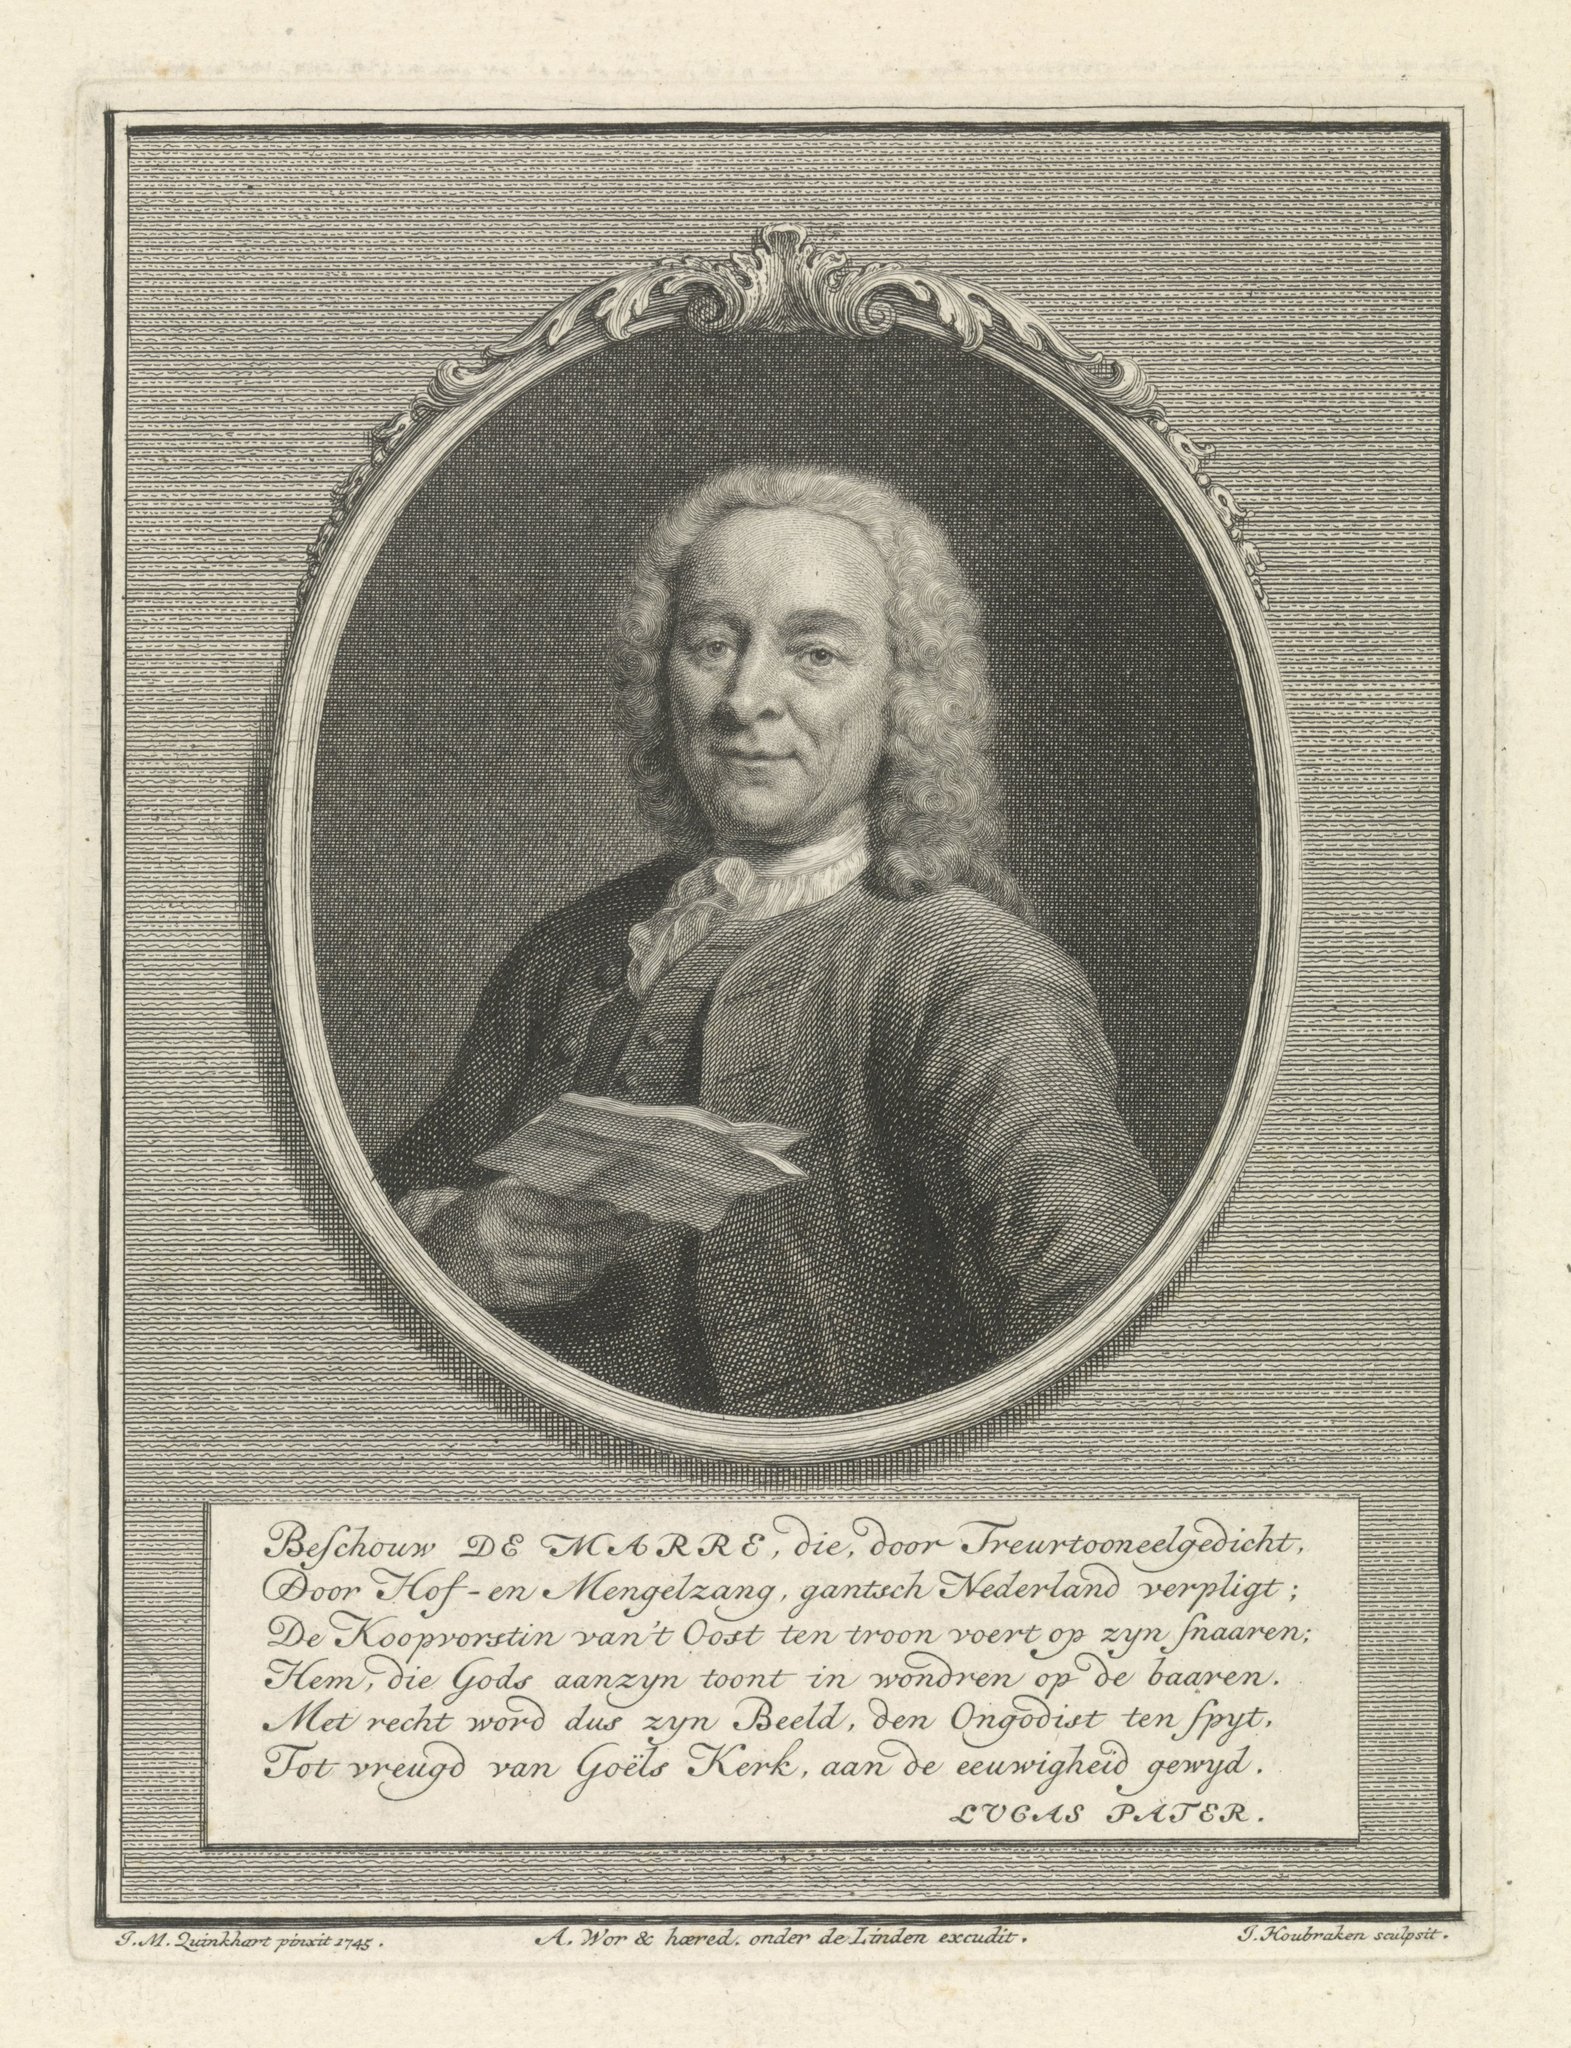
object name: print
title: Portret van Jan de Marre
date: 1745-1750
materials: paper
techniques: engraving, etching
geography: amsterdam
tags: amsterdam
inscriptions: collector's mark: Lugt 240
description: Buste naar links van Jan de Marre in een ovaal medaillon, in zijn rechterhand een vel papier. Onder het portret een zesregelig vers in het Nederlands.